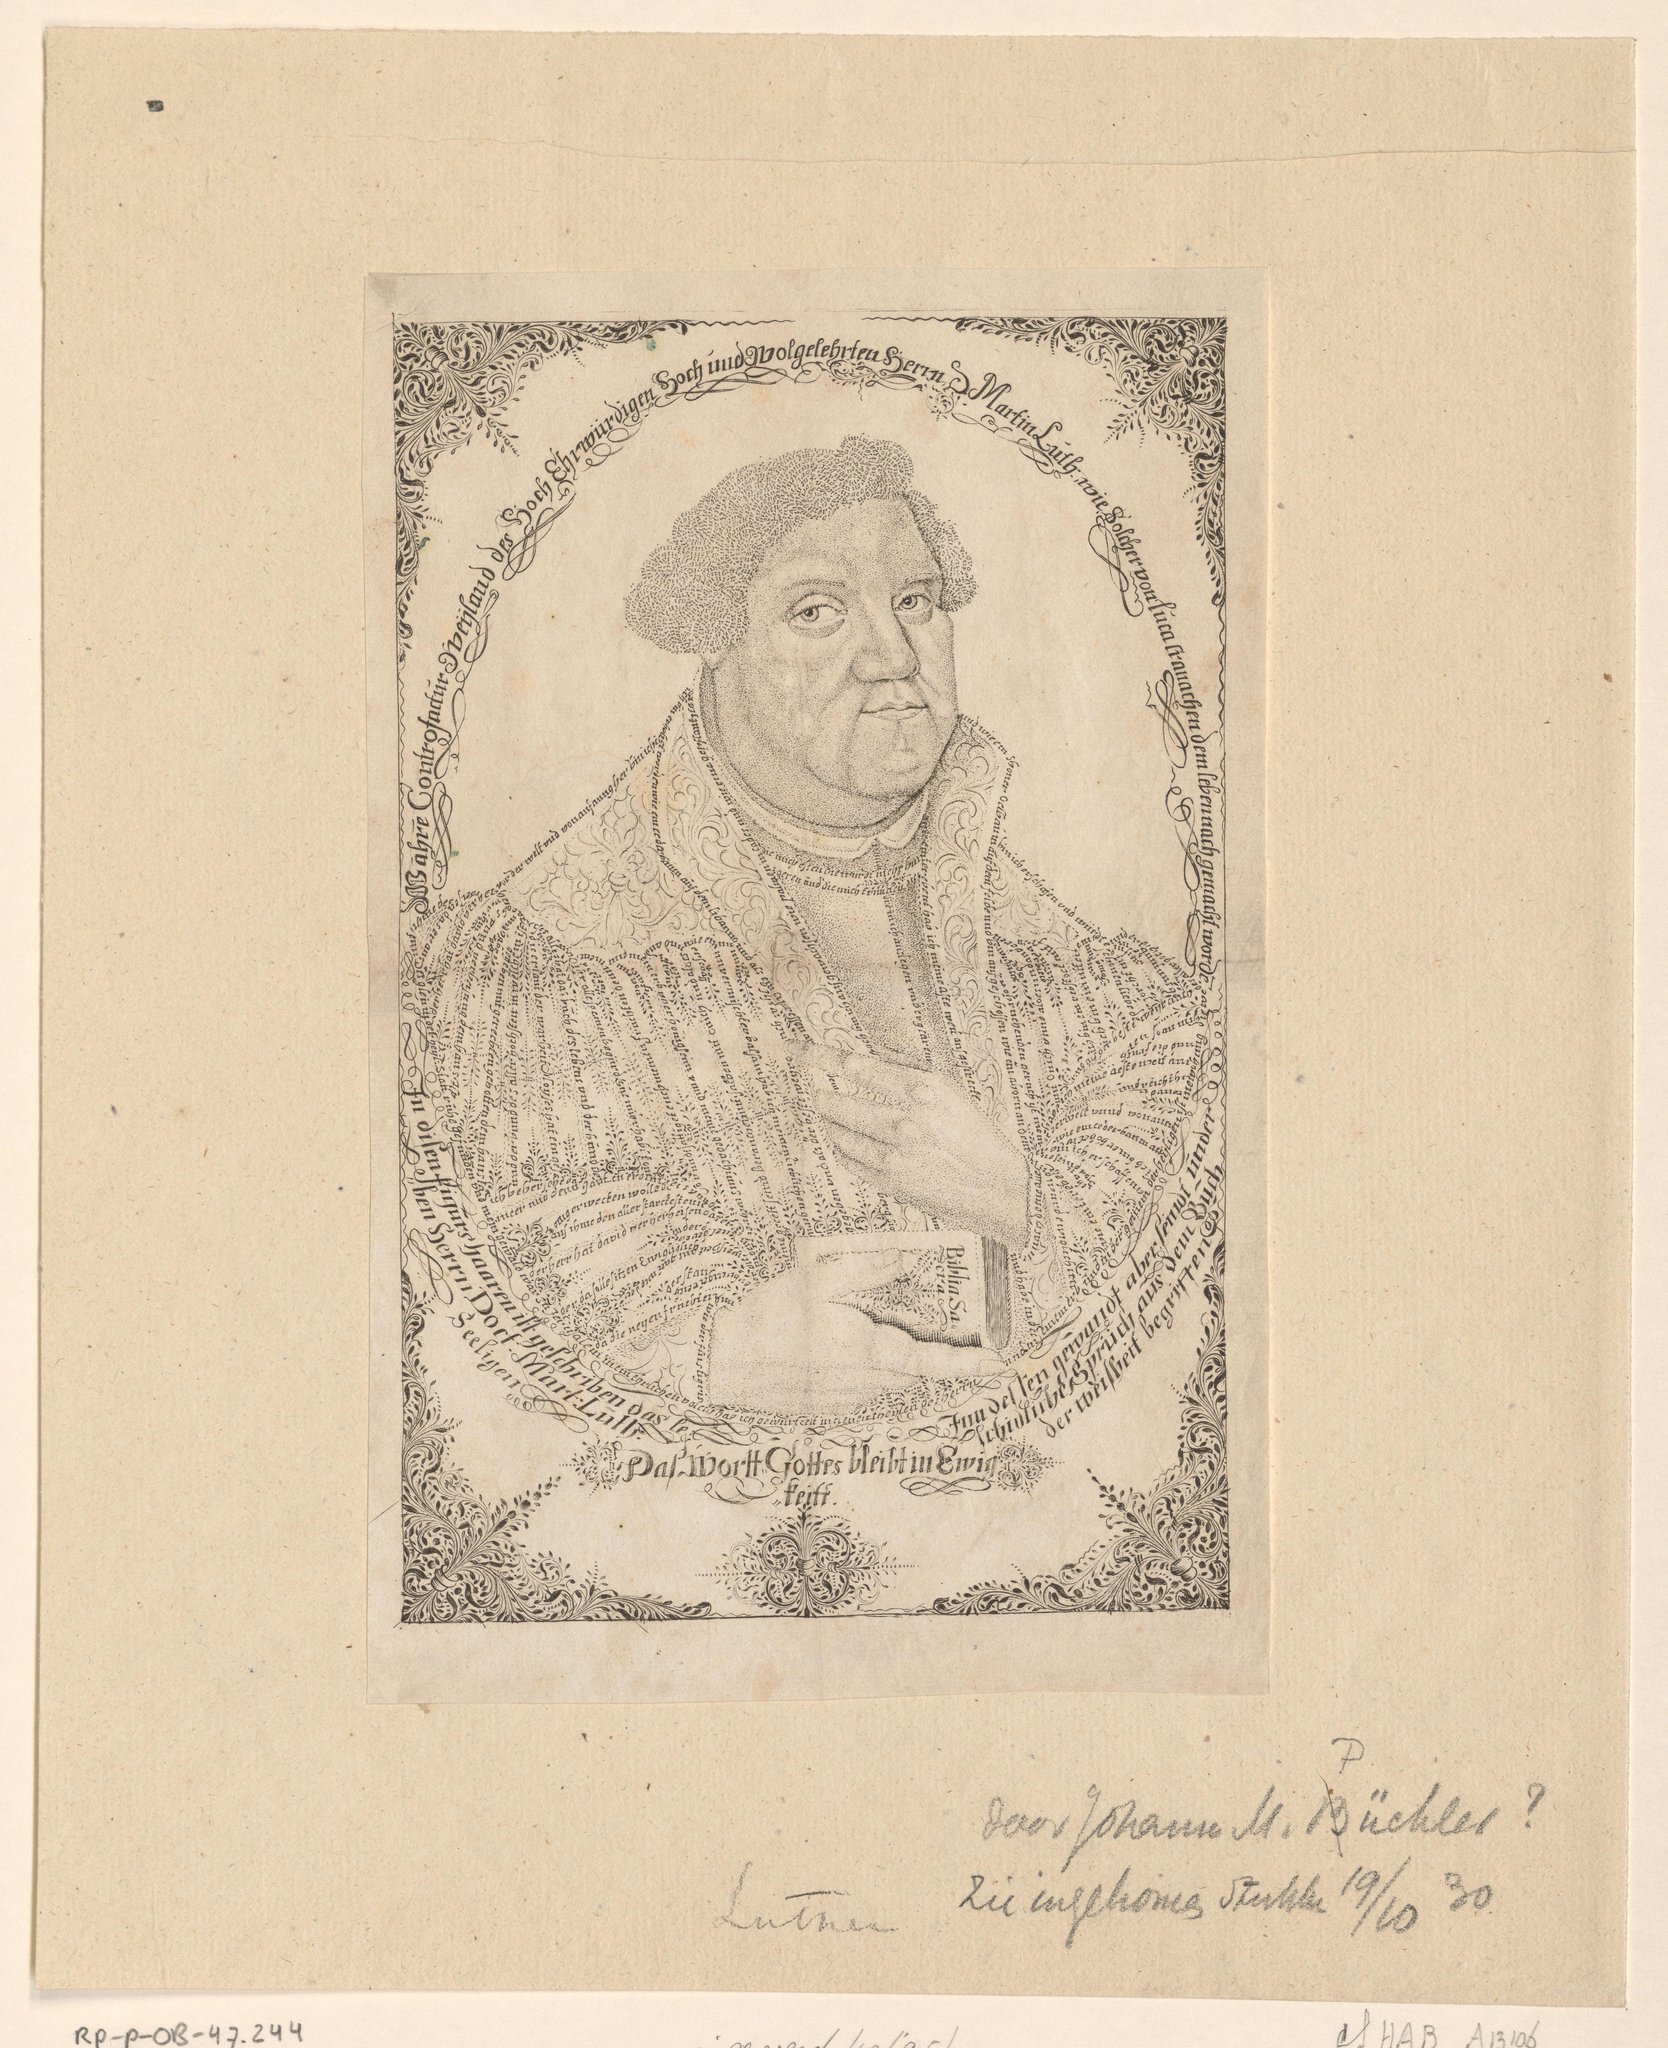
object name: print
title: Portret van Martin Luther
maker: johann michael püchler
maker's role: print maker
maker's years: 1680-1702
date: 1680-1702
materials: paper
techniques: engraving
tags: priest, martin luther, theologian, historical persons, the bible as a book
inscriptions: collector's mark: Lugt 2228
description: Portret, deels opgebouwd uit tekst in het Duits.